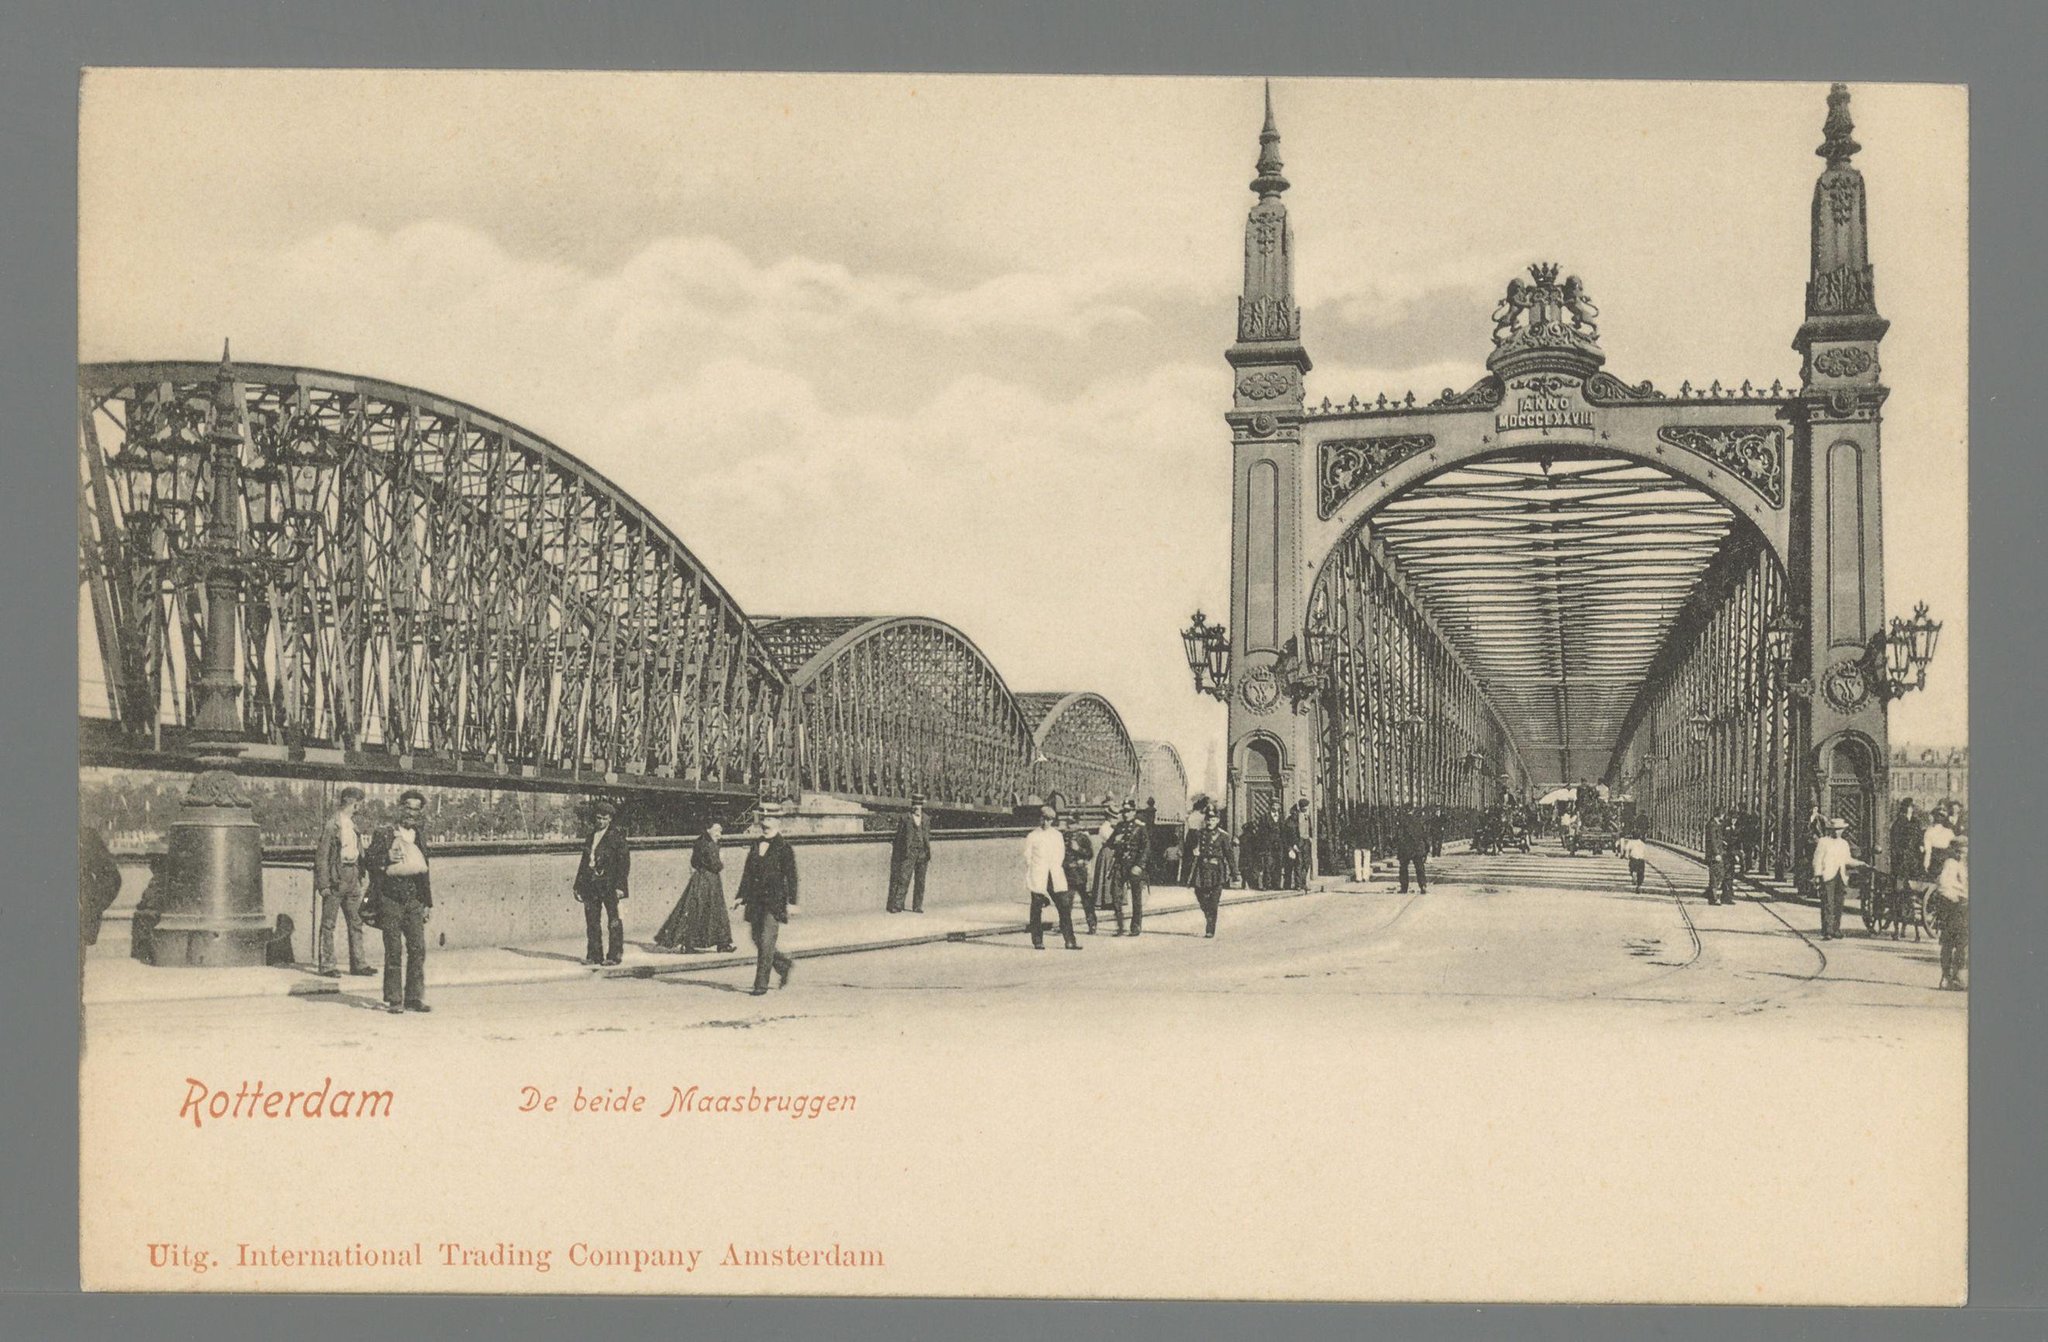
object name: photomechanical print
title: Rotterdam. De beide Maasbruggen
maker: Anonymous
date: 1897-1905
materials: cardboard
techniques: photograph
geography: amsterdam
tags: bridge in city across river, canal, etc.